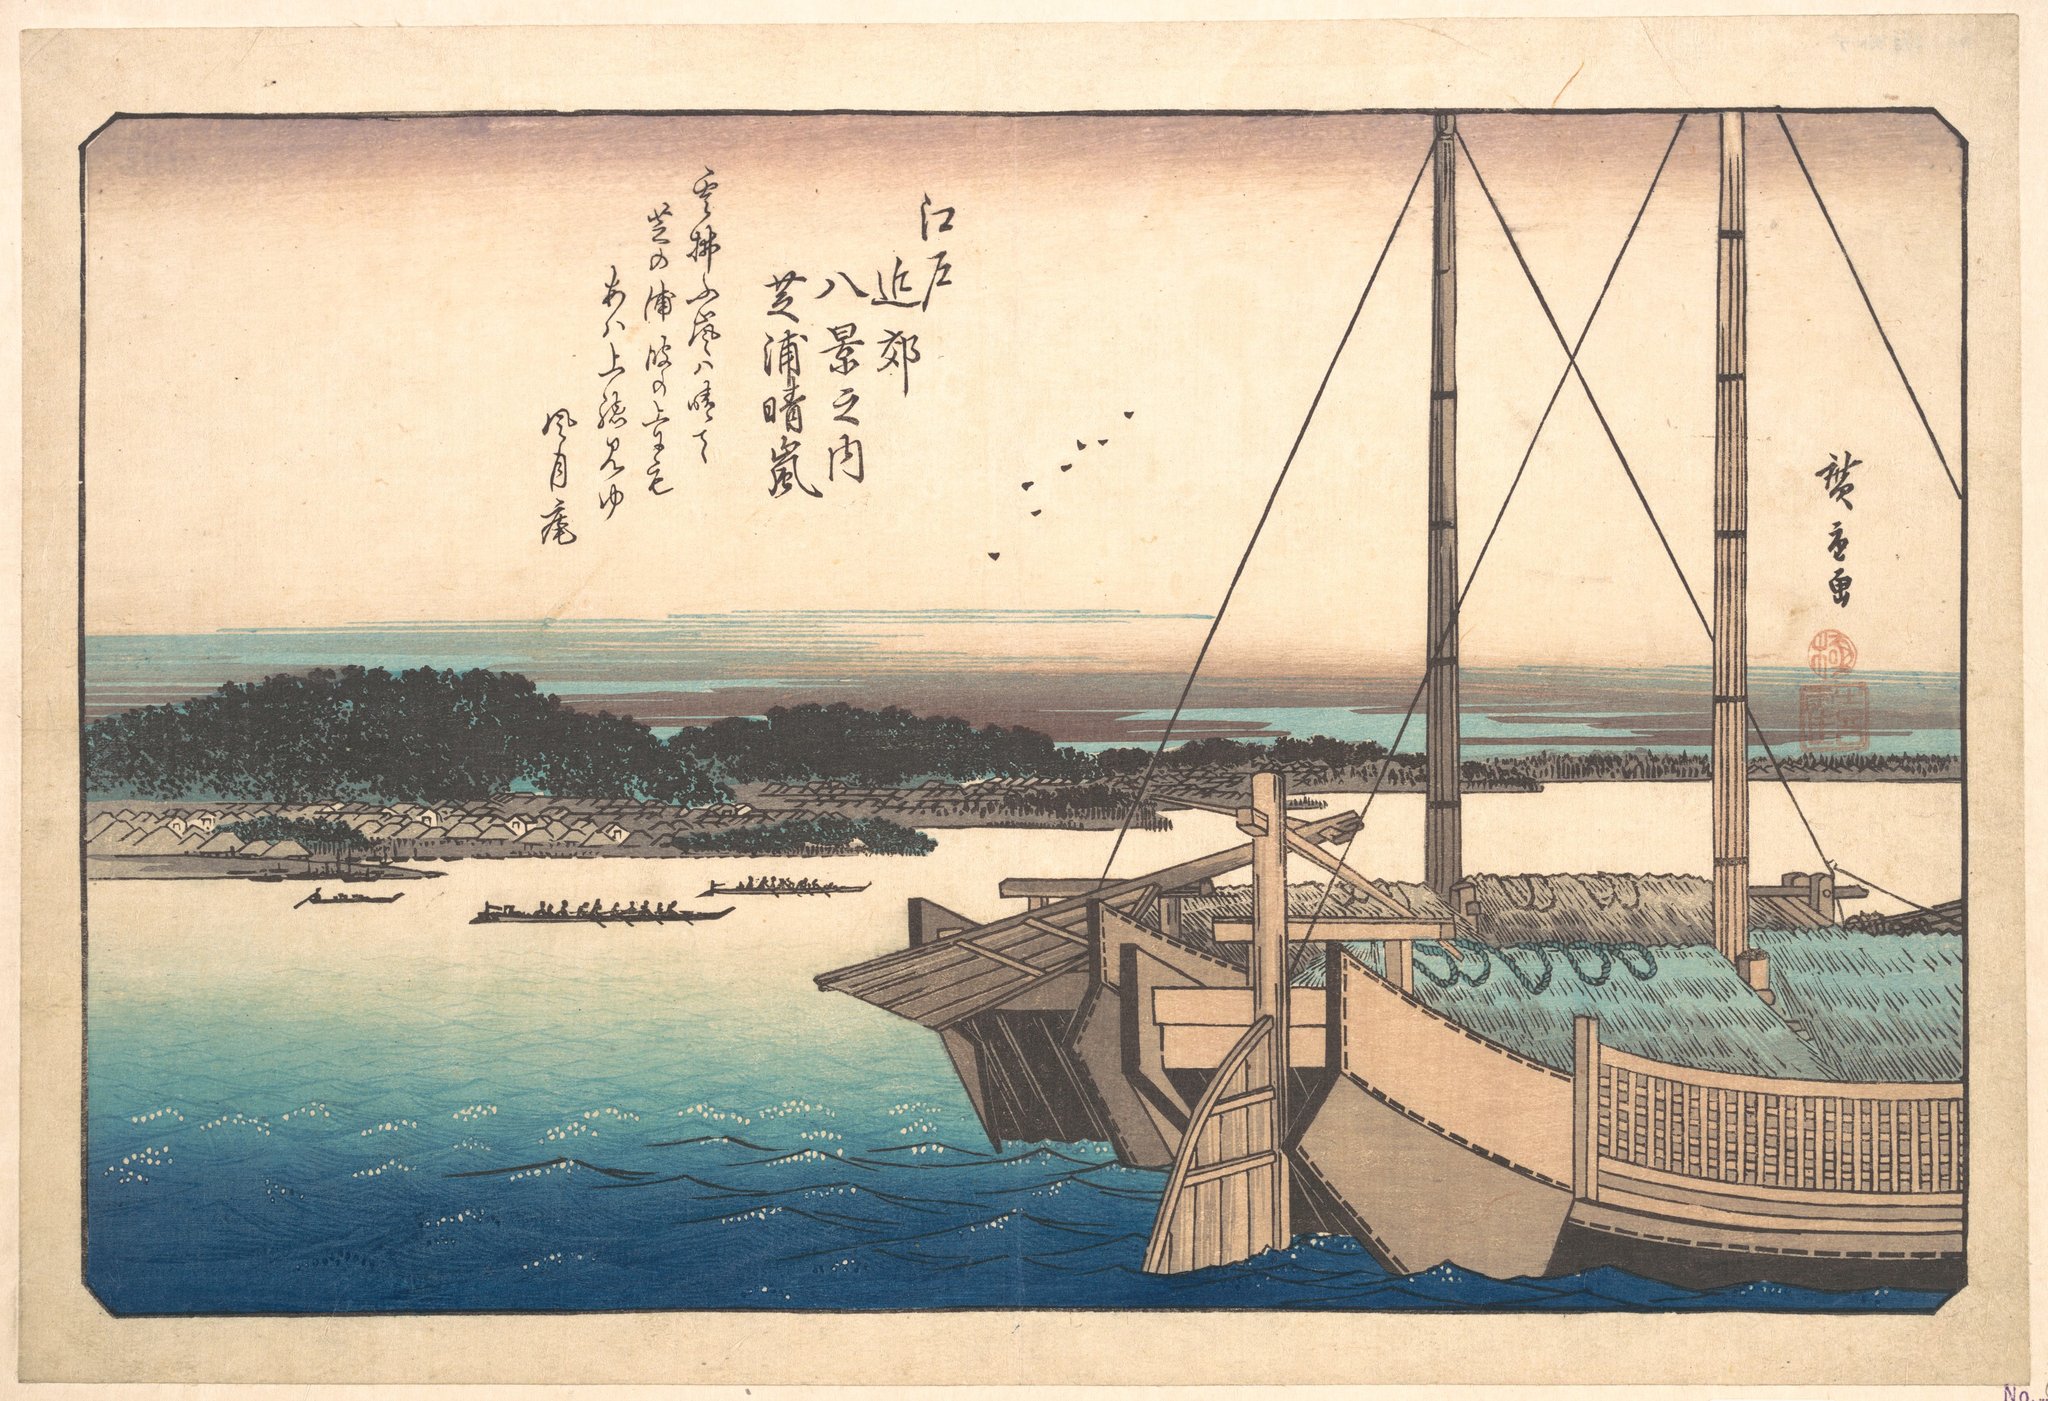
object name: print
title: Clearing Weather at Shibaura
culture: japanese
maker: utagawa hiroshige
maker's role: artist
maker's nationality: japanese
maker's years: 1797-1858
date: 1838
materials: ink, paper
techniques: woodblock print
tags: boats